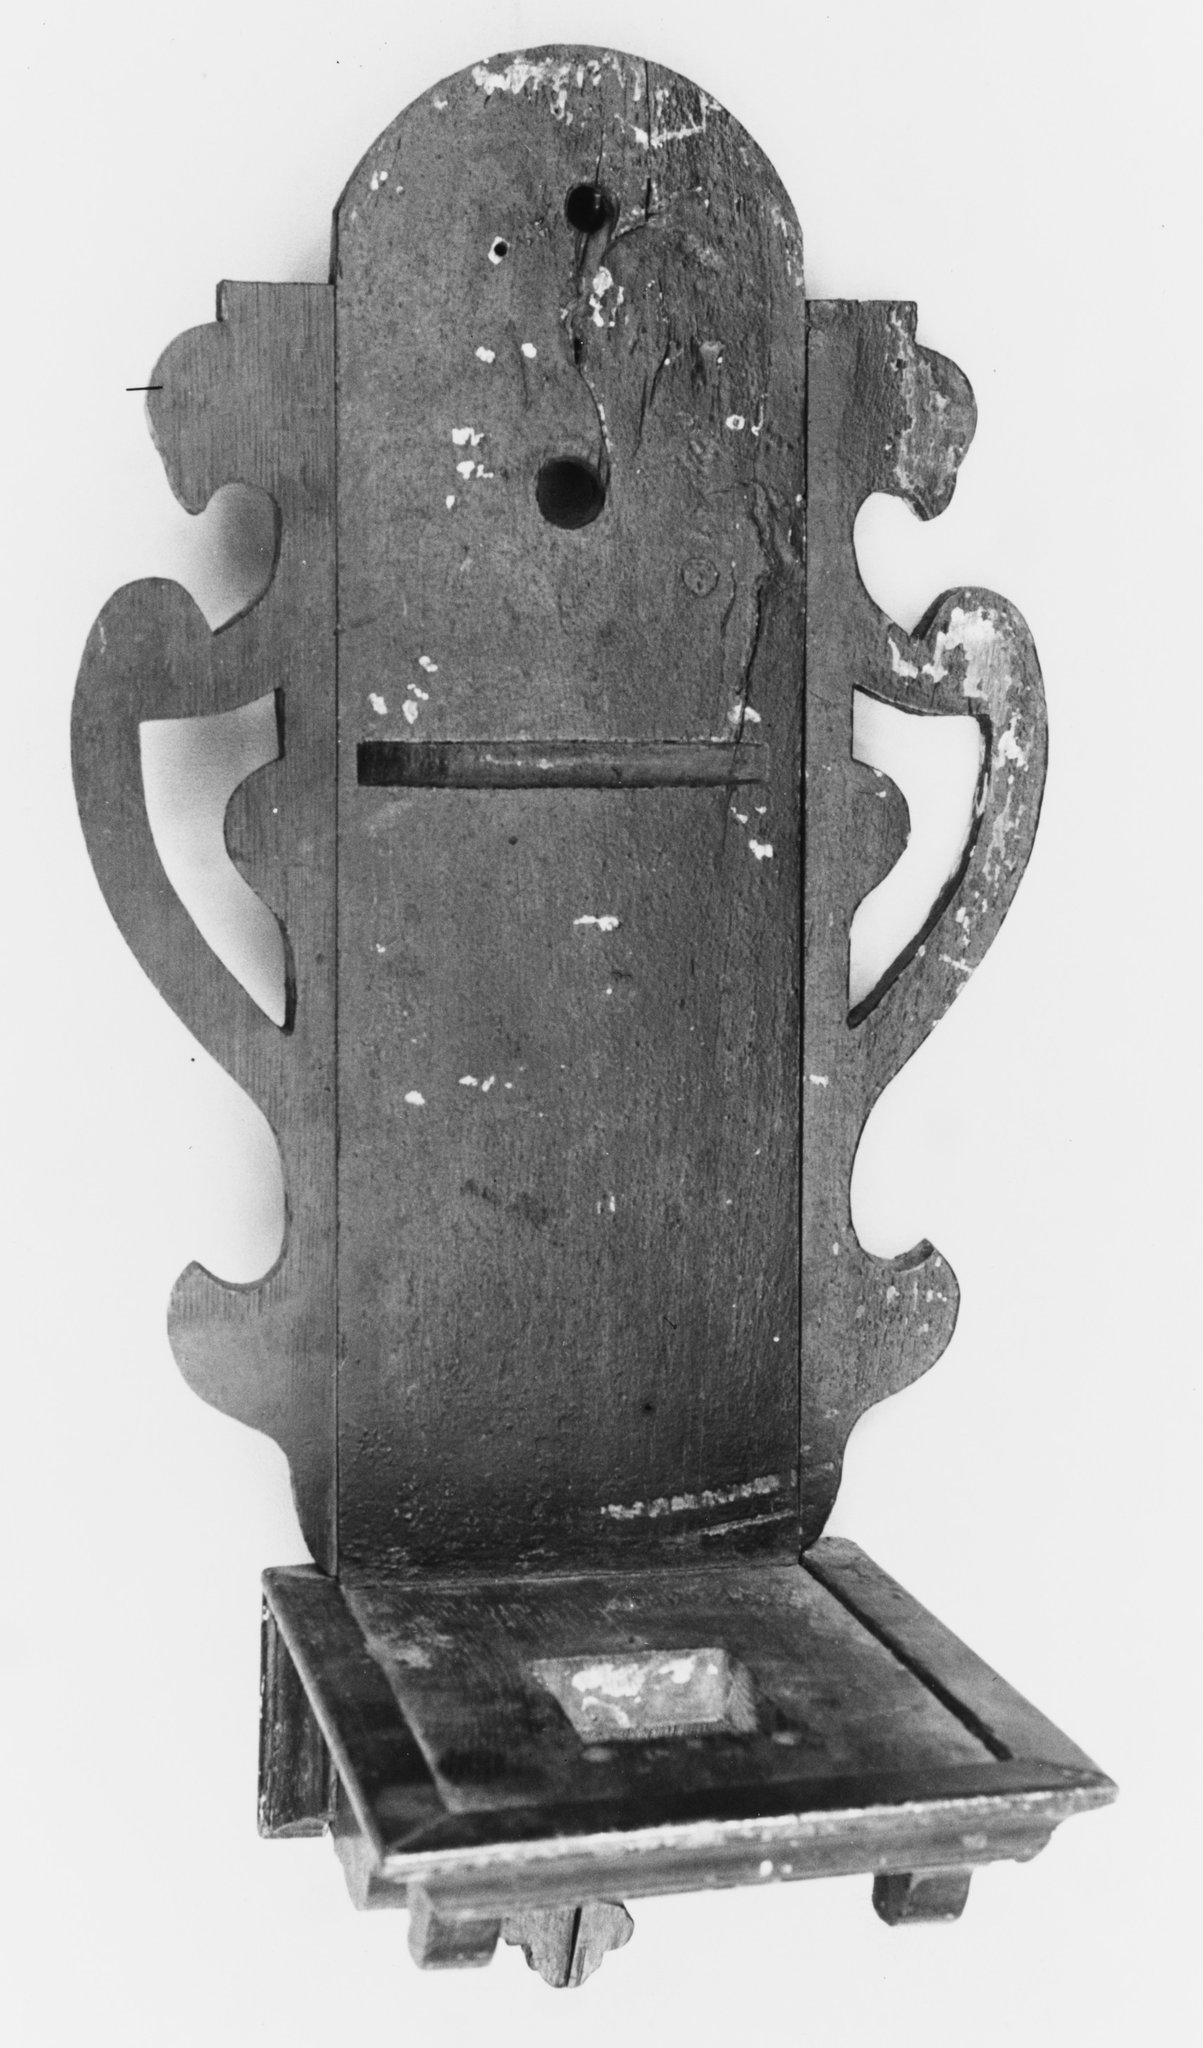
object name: bracket clock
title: Clock bracket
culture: british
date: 1690-1700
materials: wood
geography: england